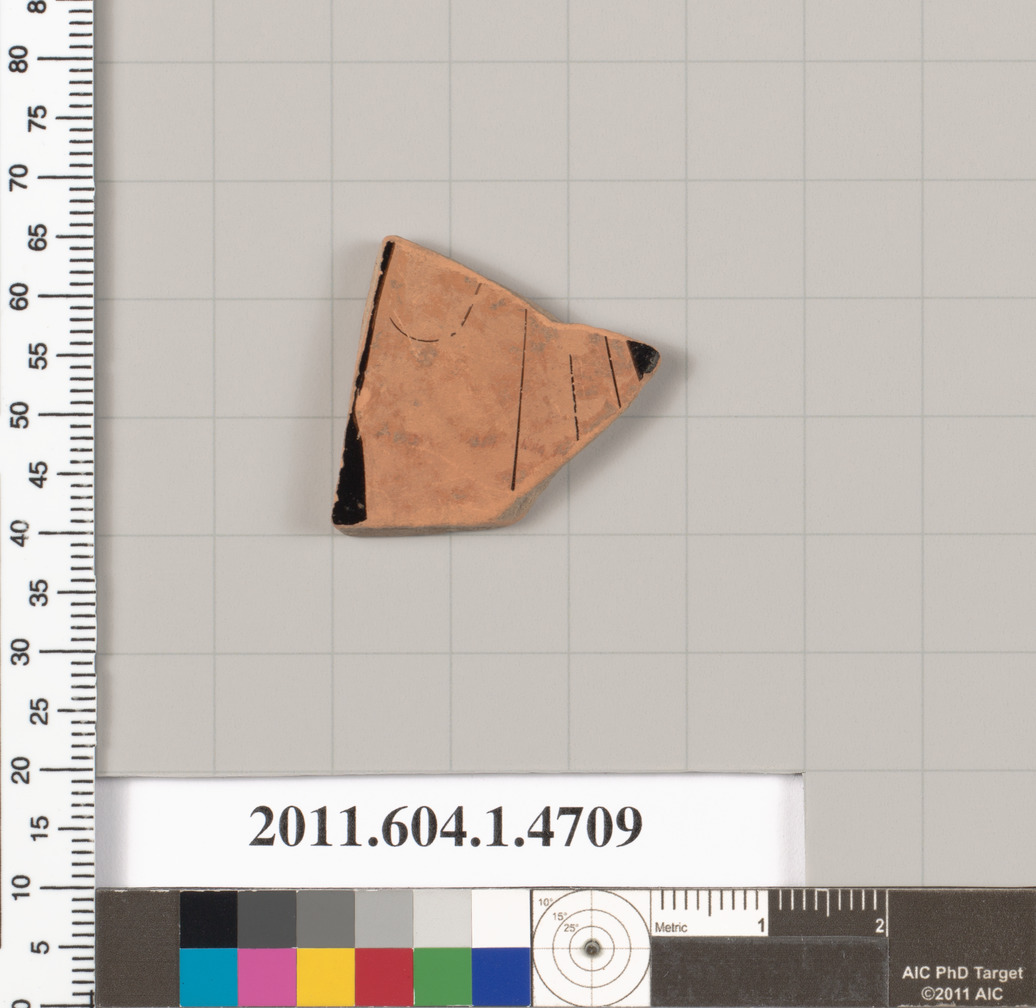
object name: kylix fragment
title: Terracotta fragment of a kylix (drinking cup)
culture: greek, attic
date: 475-451 BCE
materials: terracotta